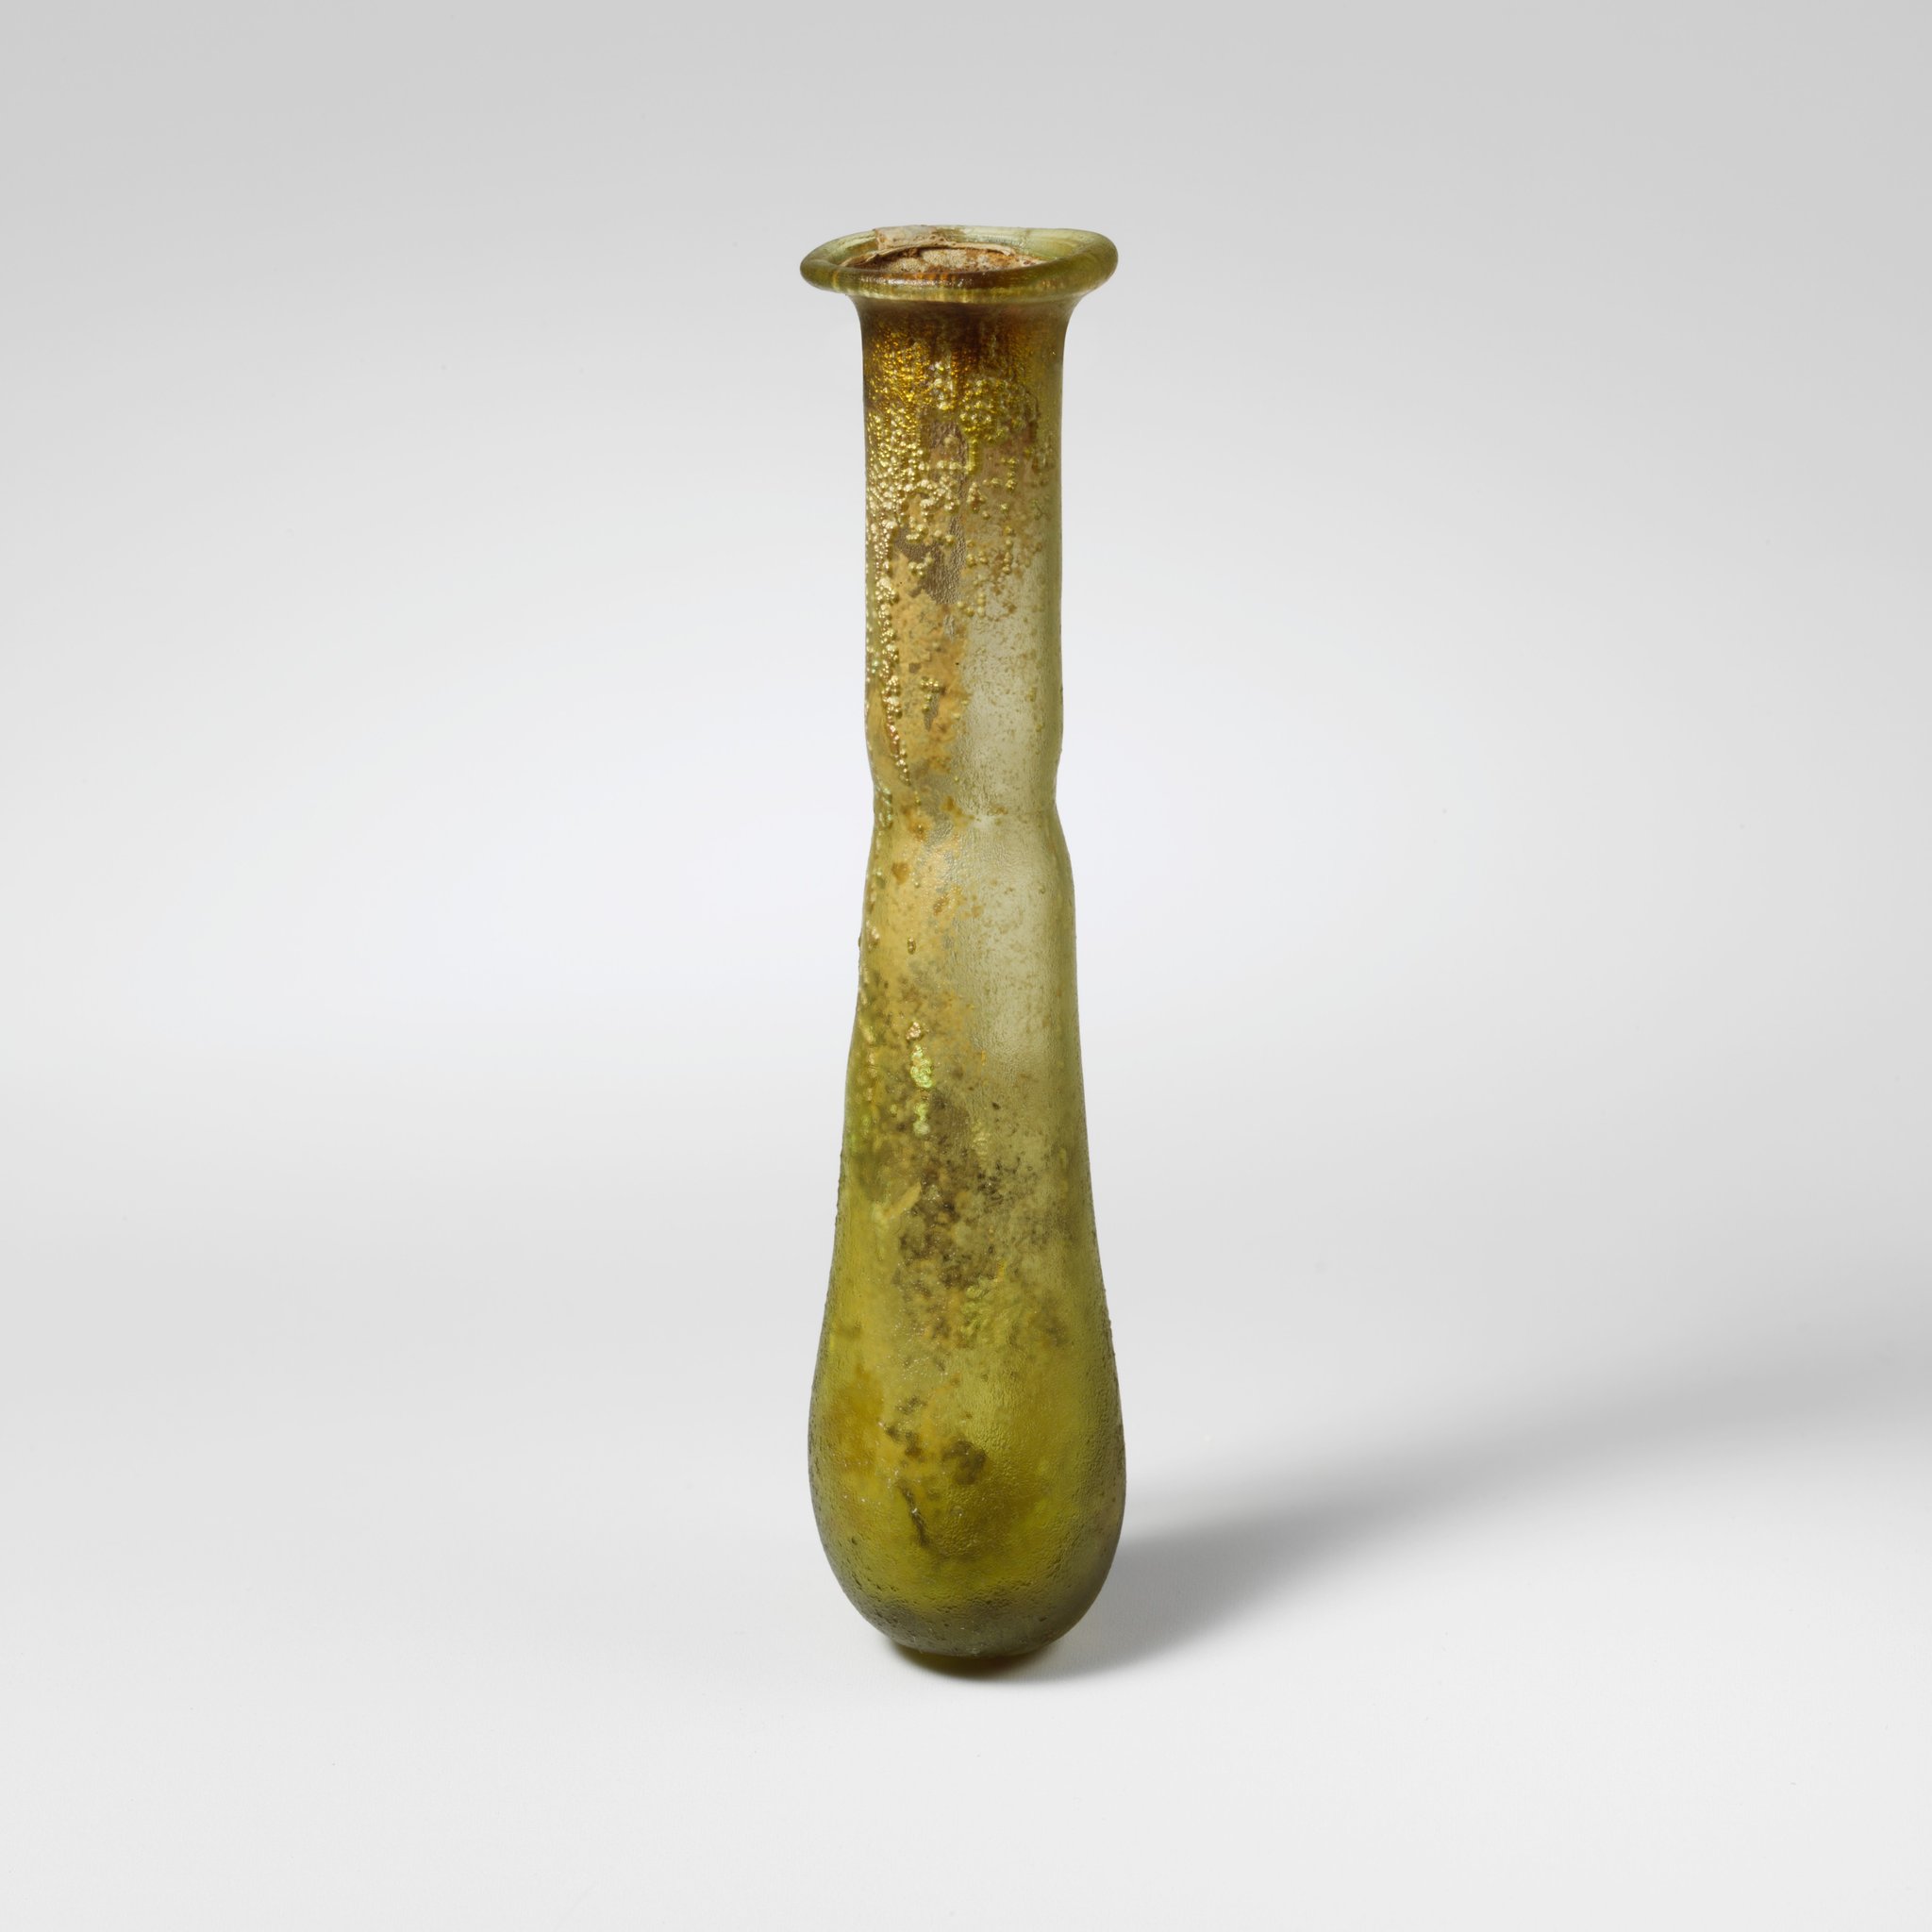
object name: perfume bottle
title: Glass perfume bottle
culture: roman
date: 34-133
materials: glass